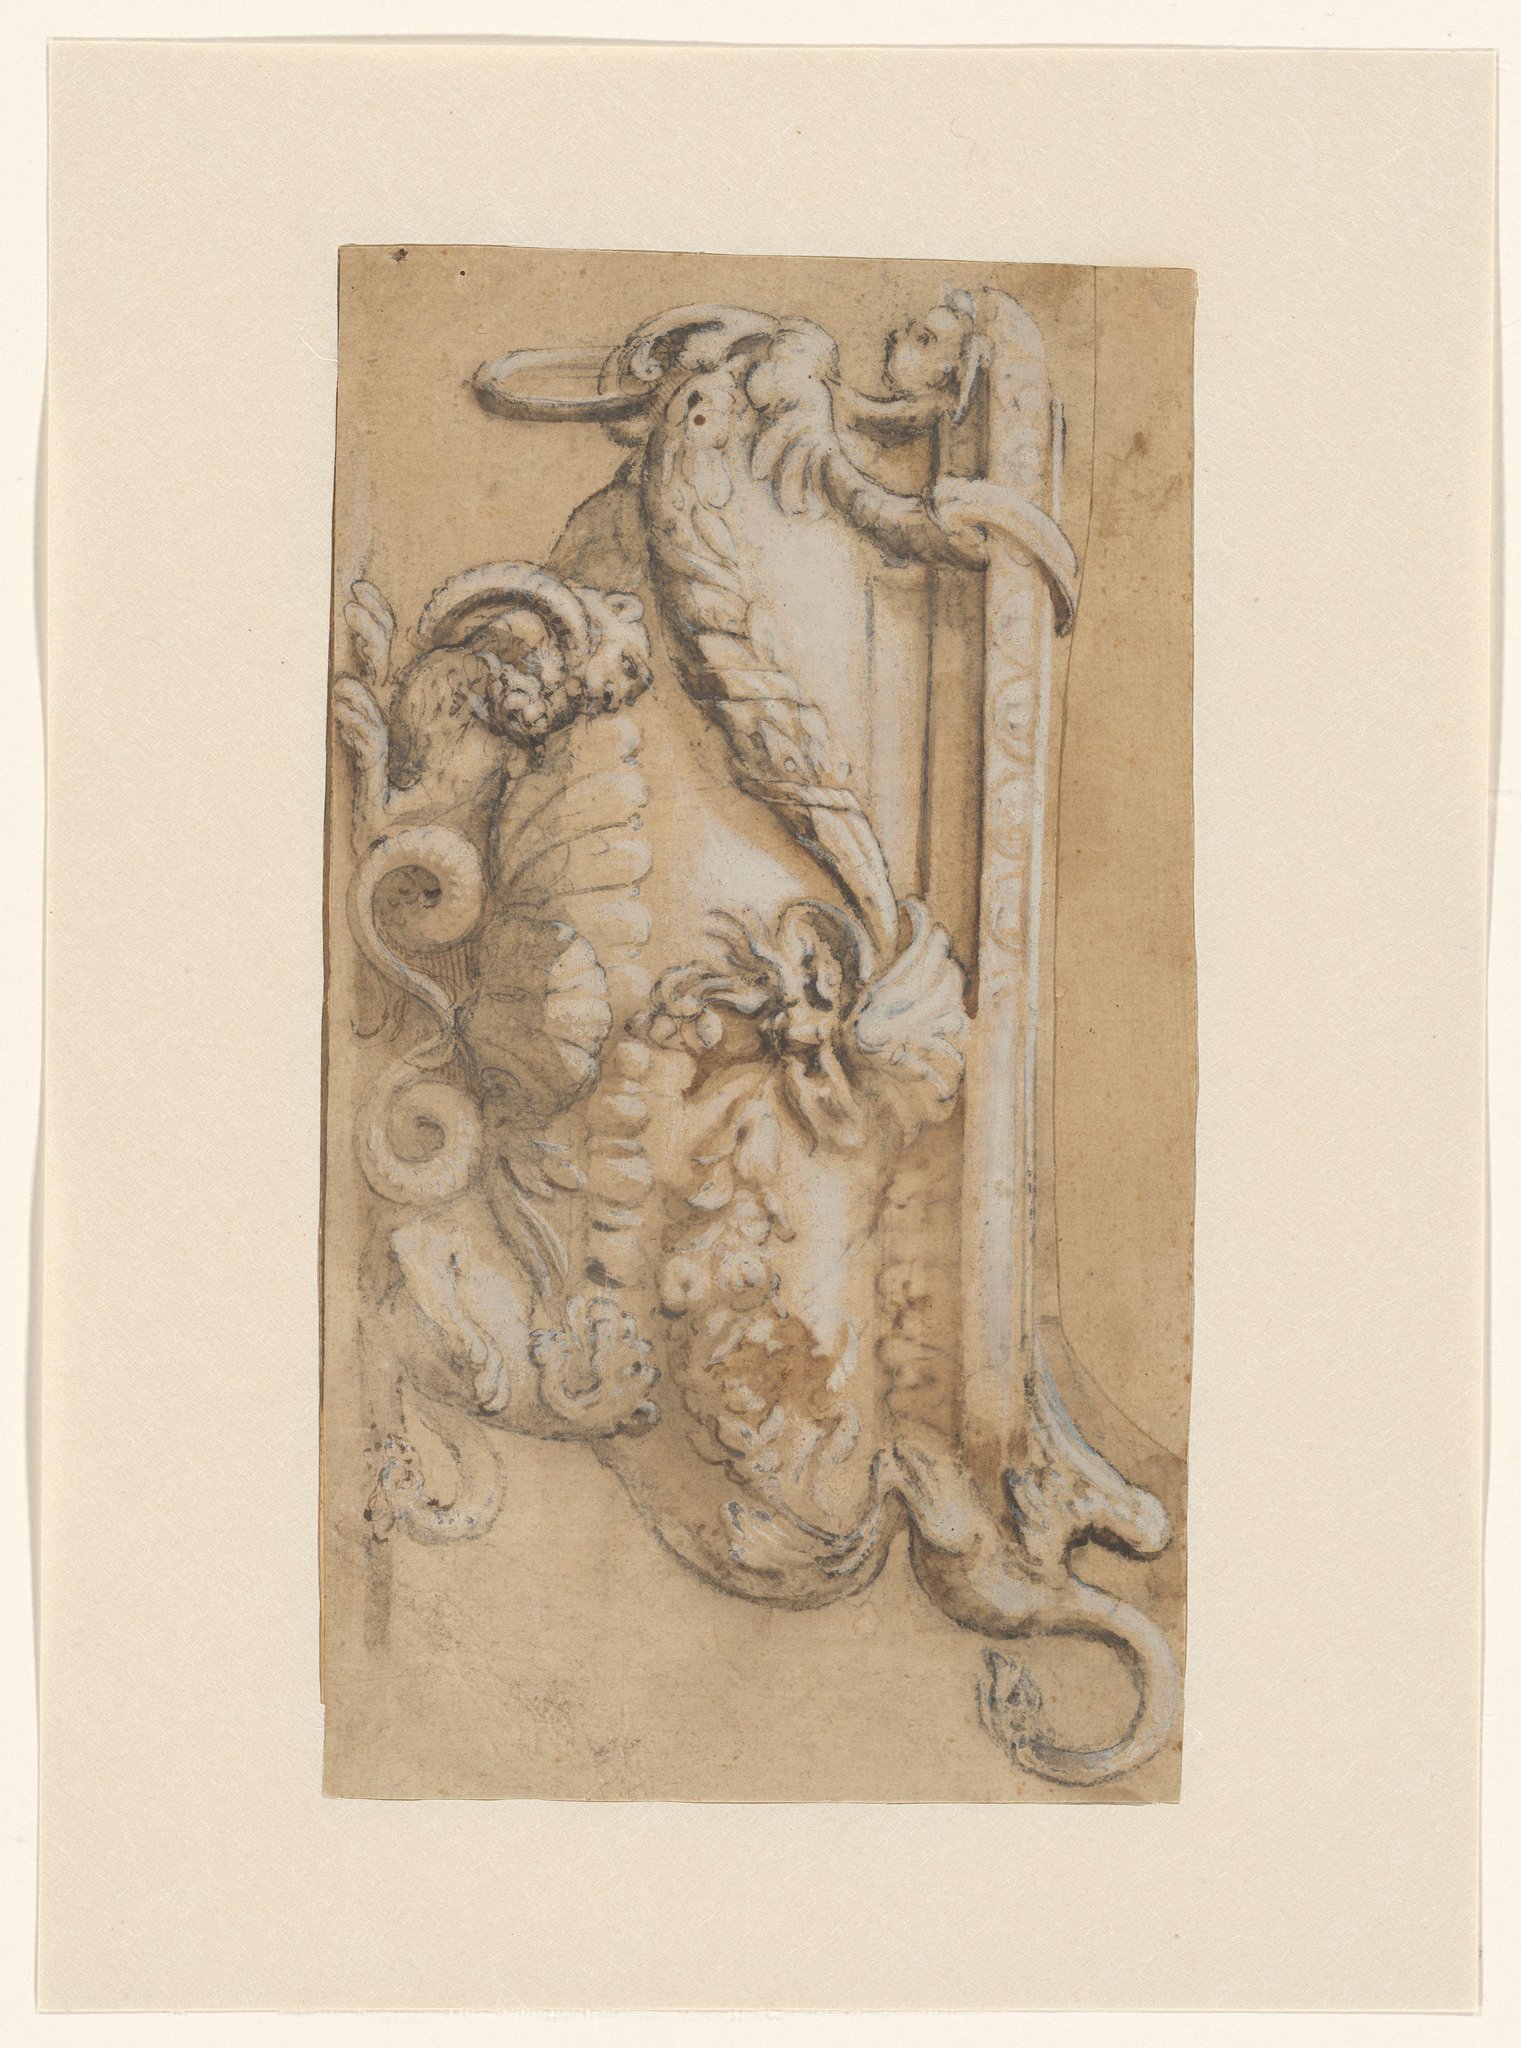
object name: drawing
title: Ontwerp voor een koelvat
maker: Anonymous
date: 1550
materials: ink, paper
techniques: brush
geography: italy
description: Ontwerp voor een koelvat met poten in de vorm van leeuwen, met alternatieve oplossingen voor de linker- en rechterhelft.